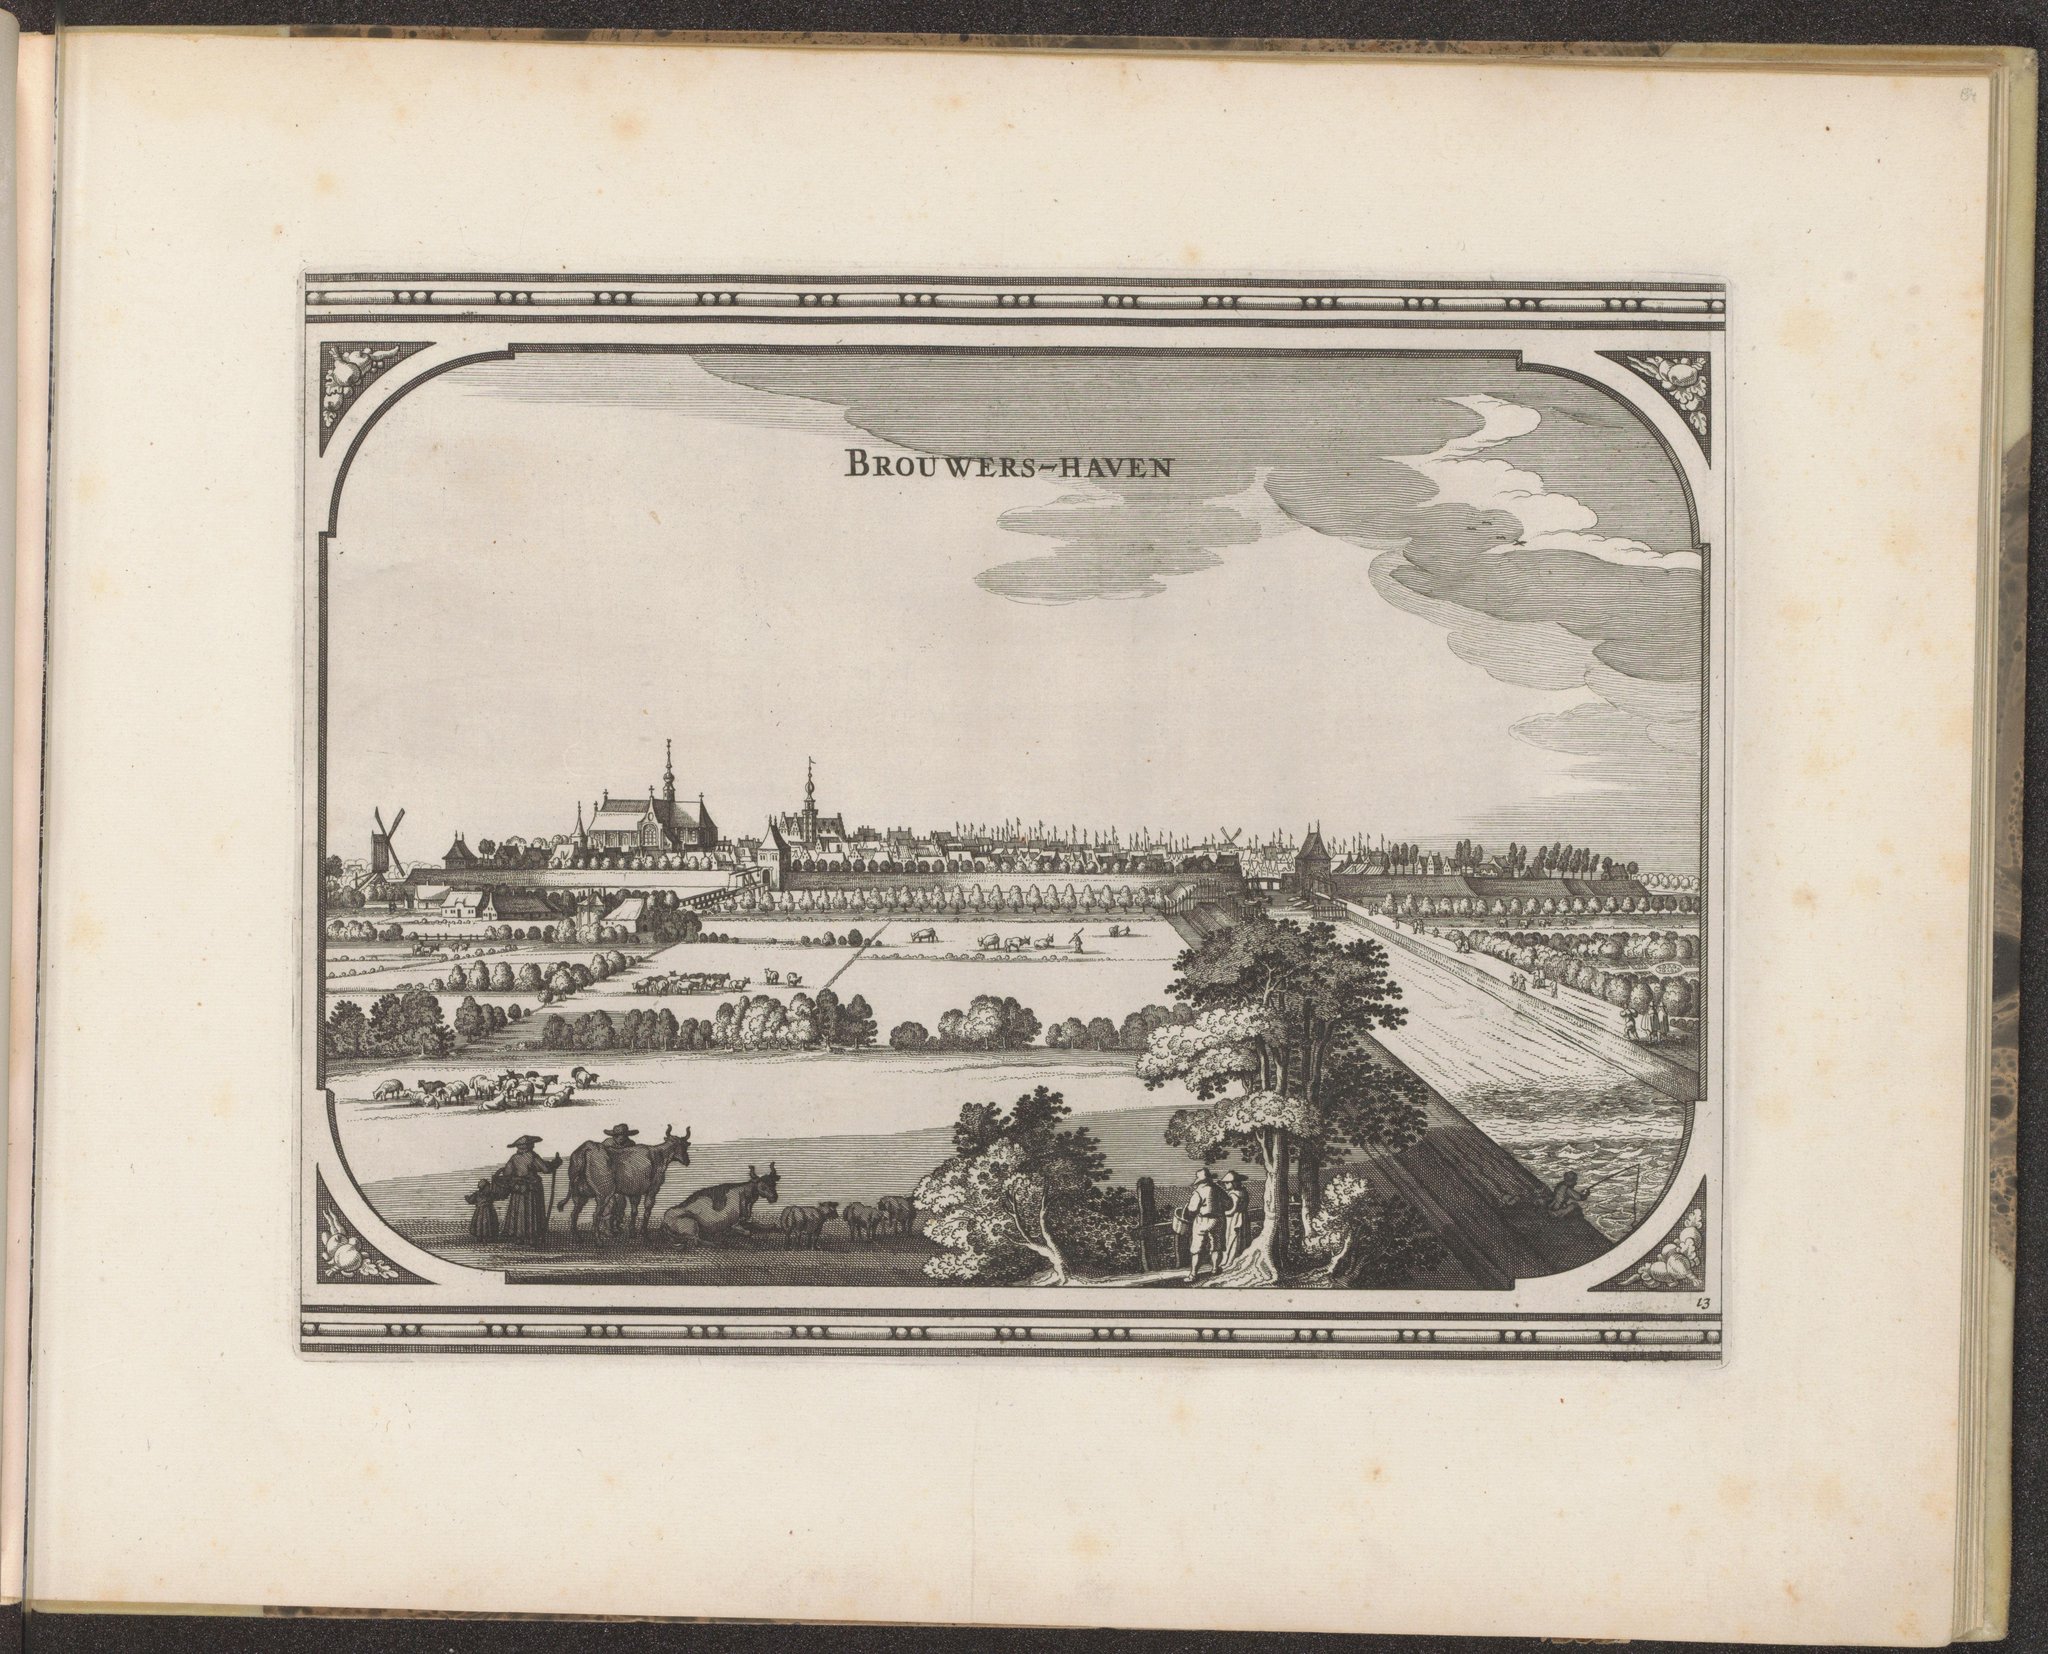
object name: album leaf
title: Speculum Zelandiae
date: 1662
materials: paper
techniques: etching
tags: city-view, and landscape with man-made constructions, fisherman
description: Gezicht op de stad Brouwershaven en de weilanden eromheen. Rechts een kanaal met een visser. Op de voorgrond staat een boerenpaar bij een hek en onder een boom. De prent maakt deel uit van een album.